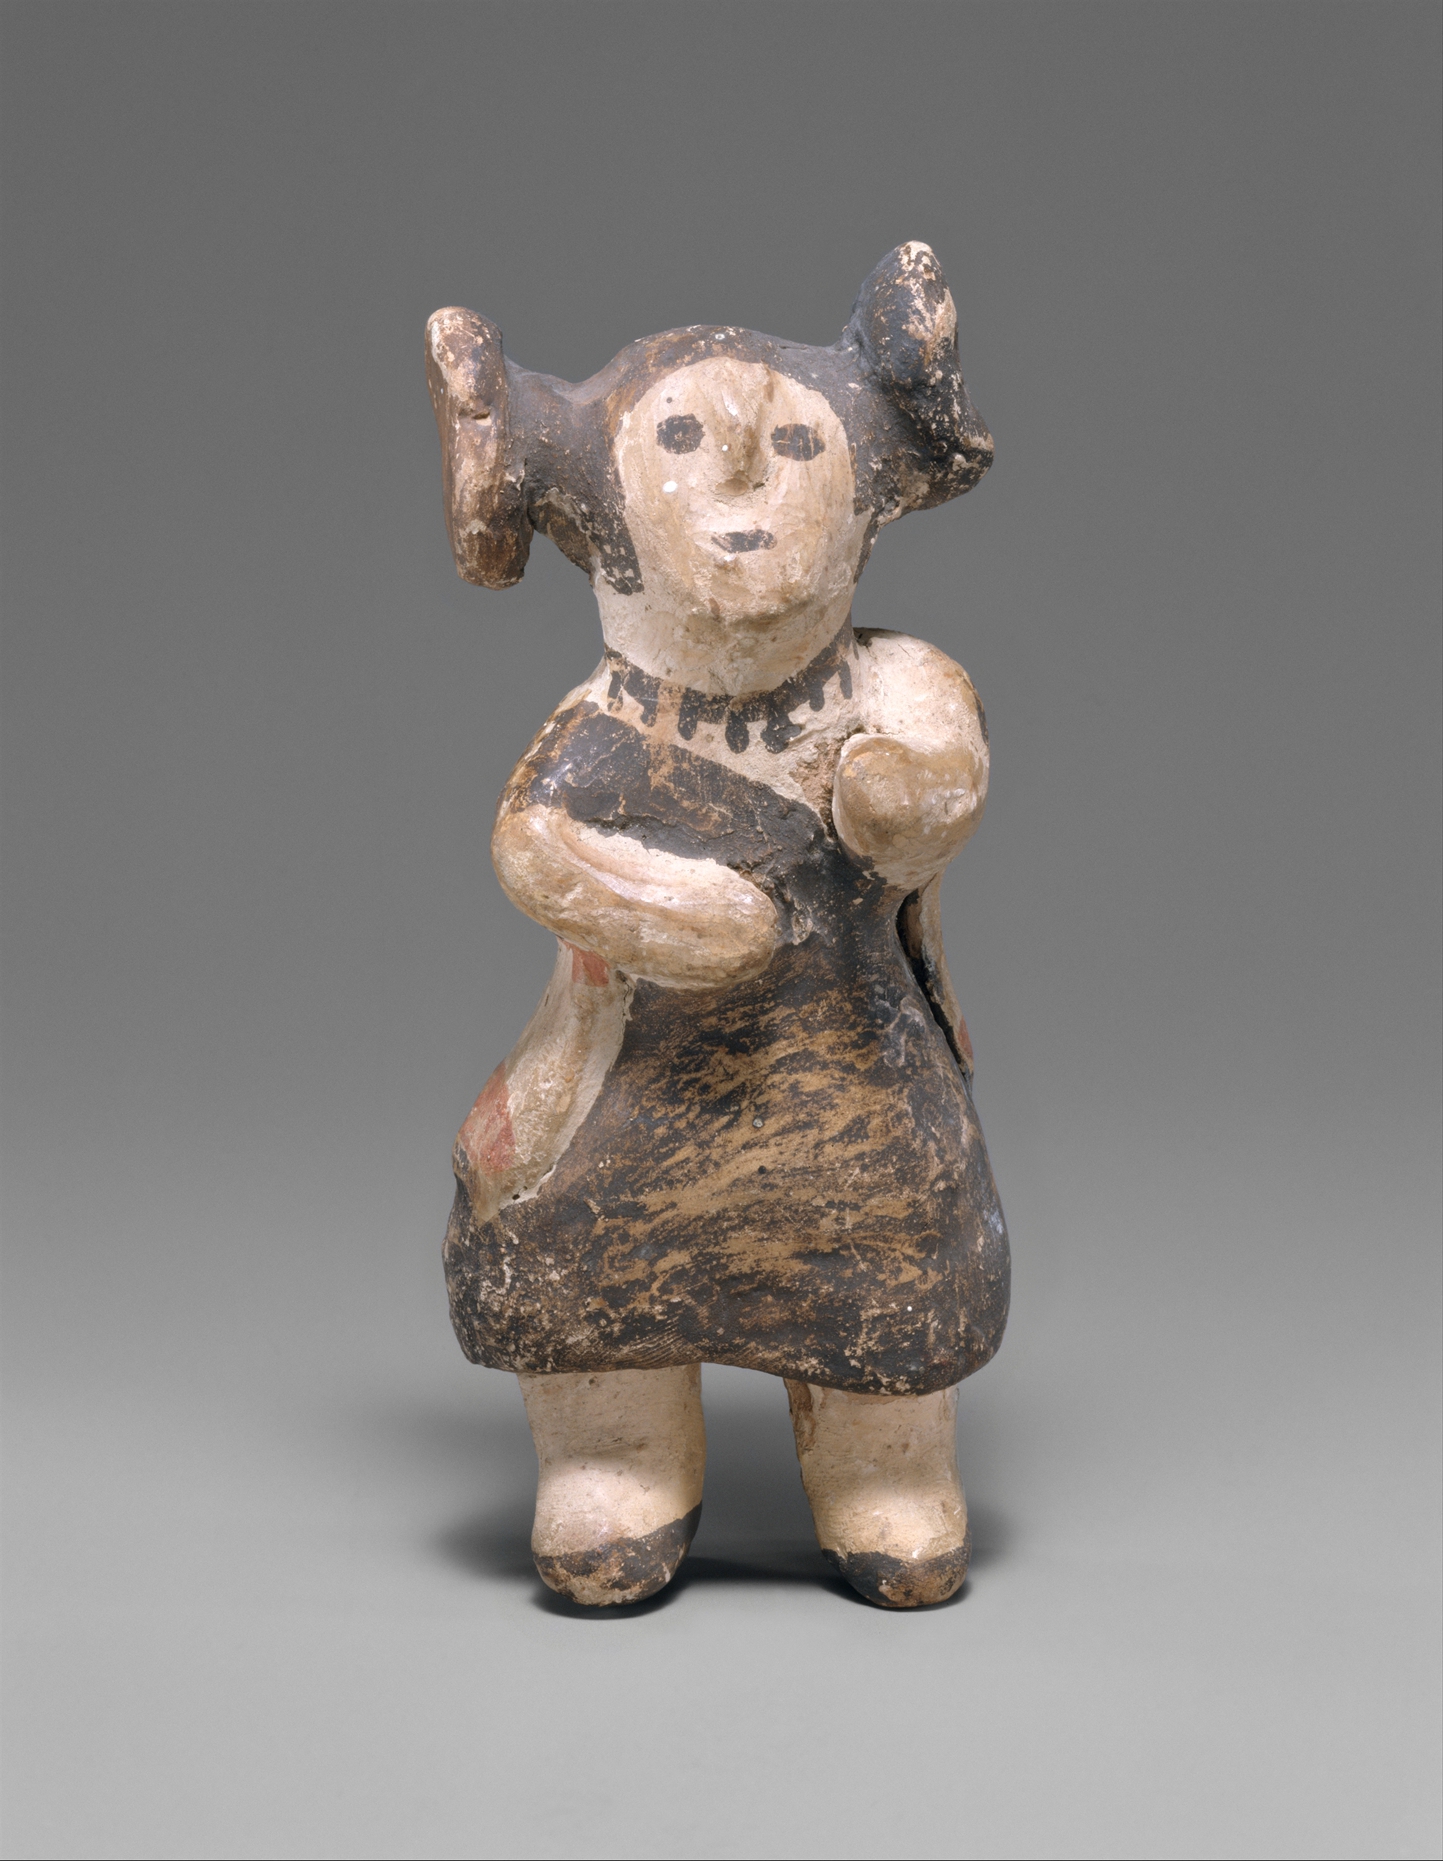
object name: doll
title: Figurine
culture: hopi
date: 1879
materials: ceramic, pigment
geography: united states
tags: women